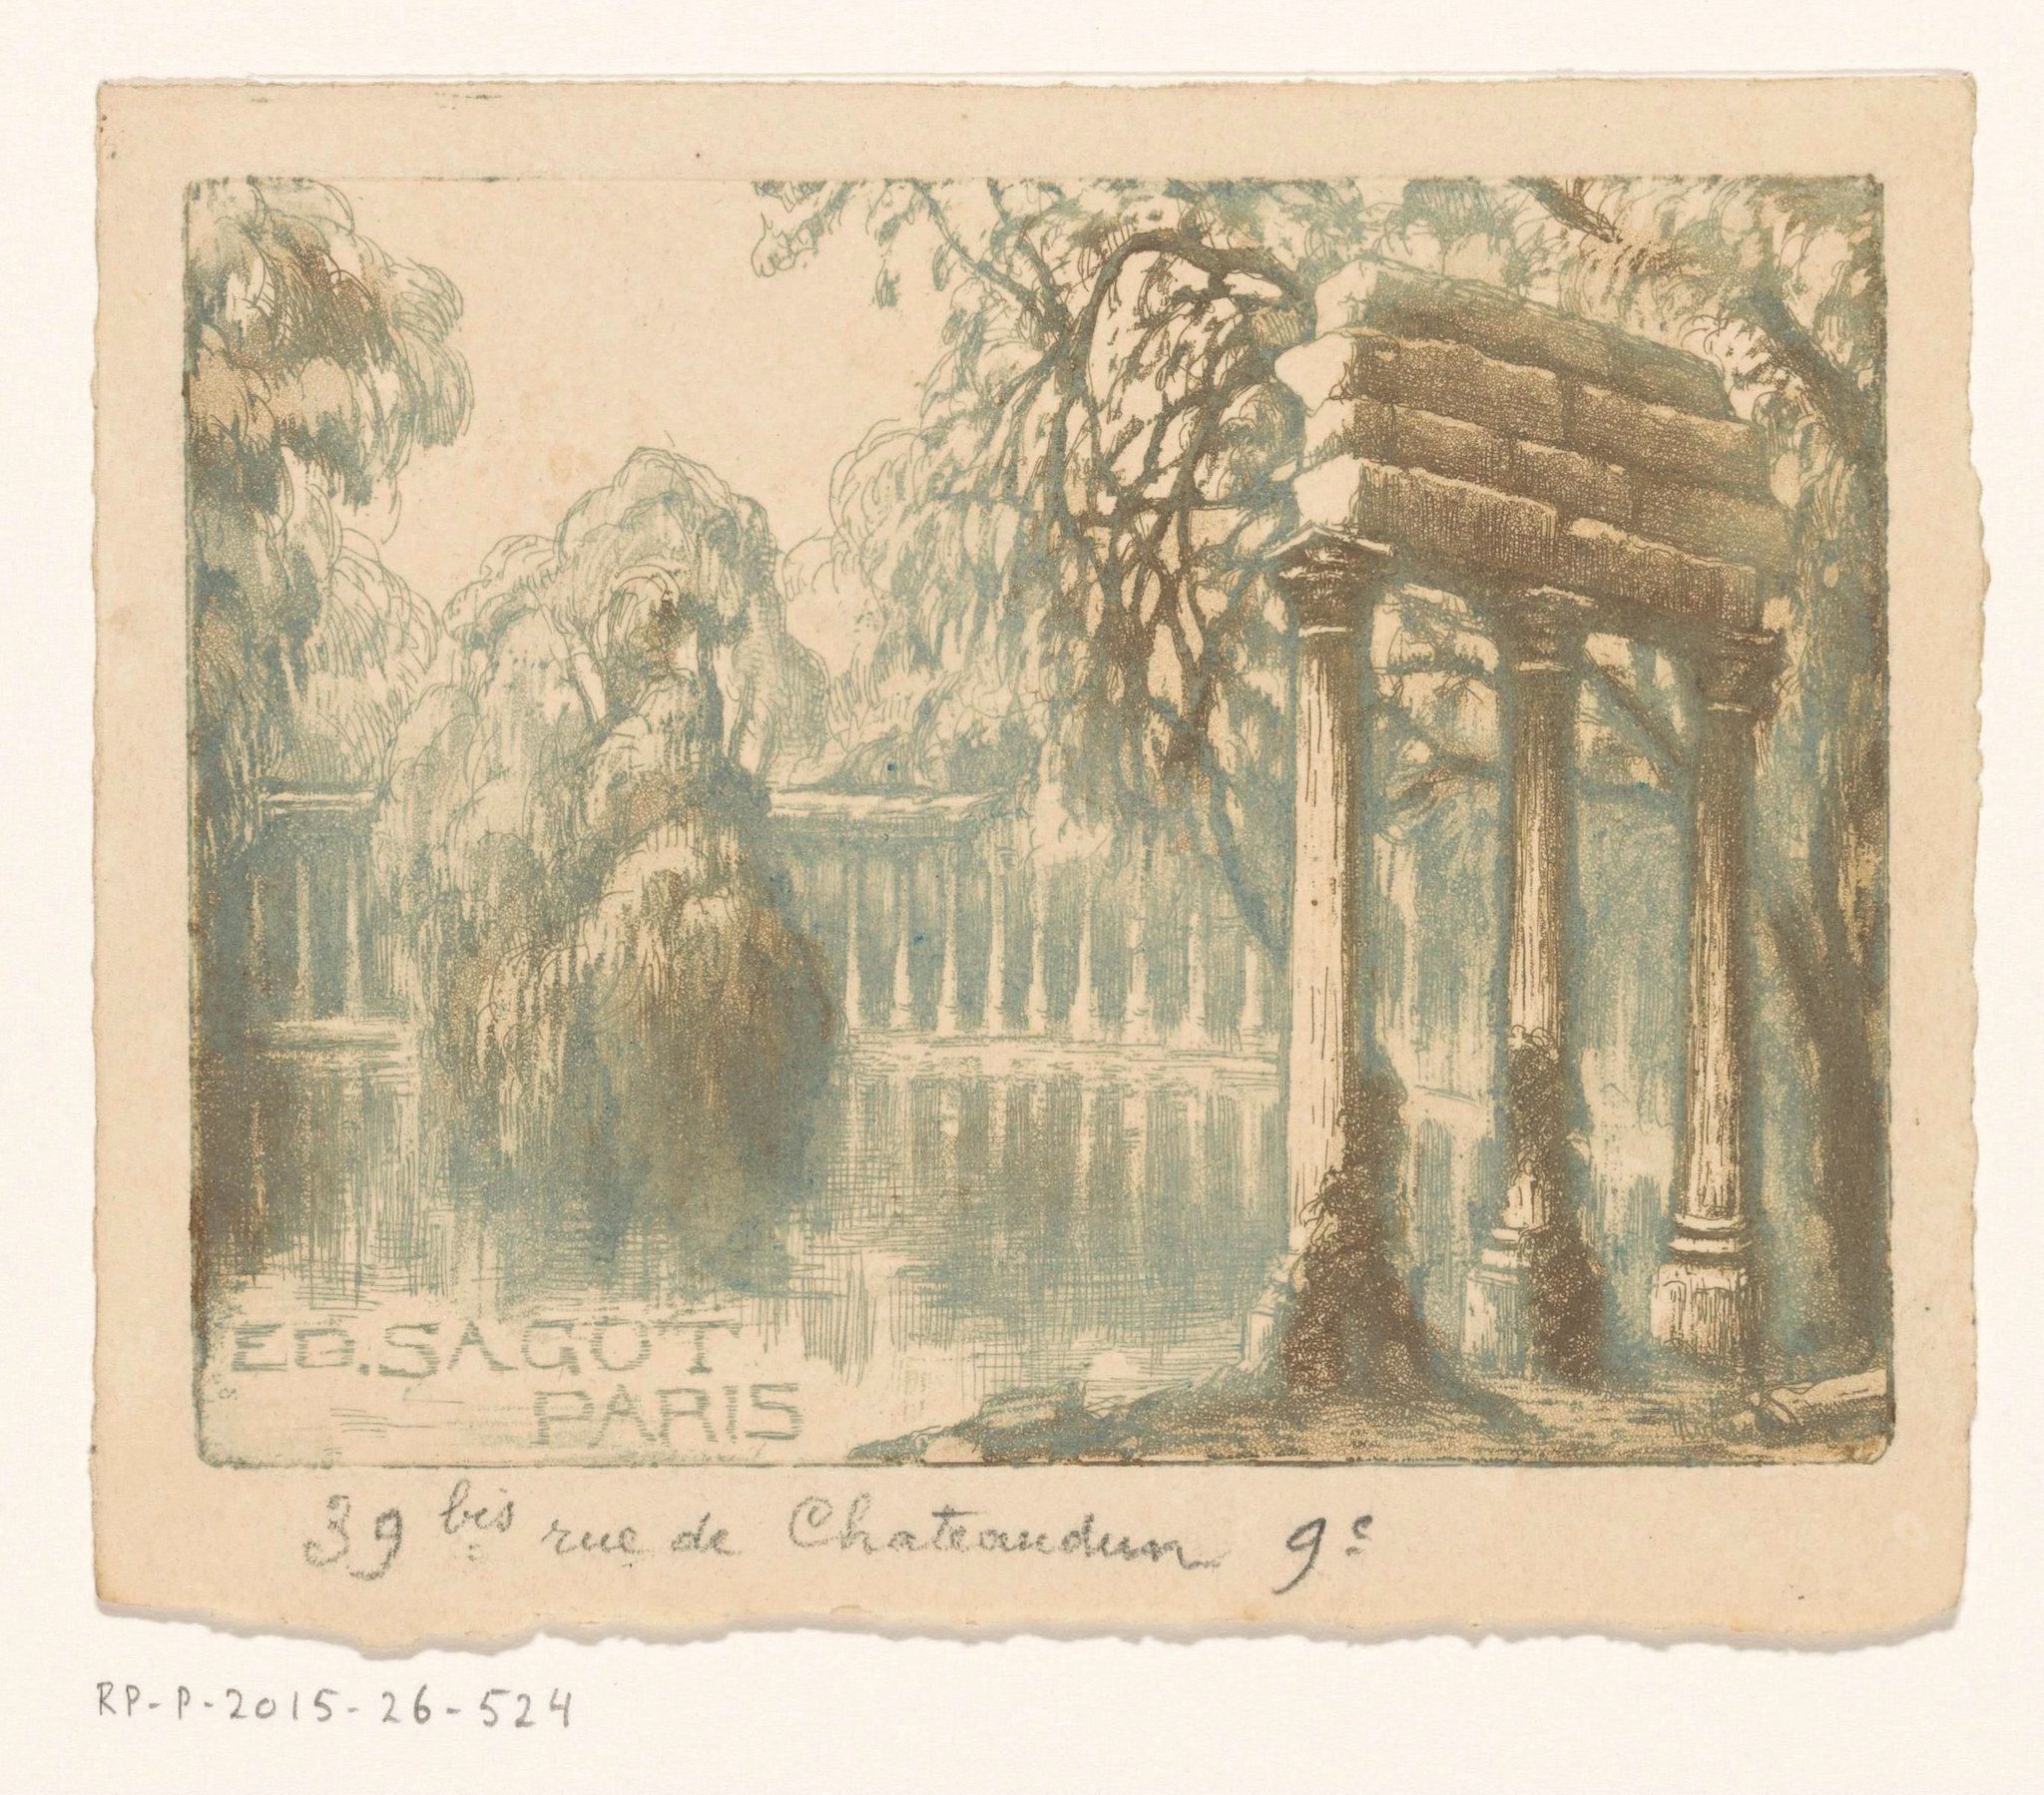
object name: visiting card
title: Visitekaartje van prenthandelaar Edmond Sagot te Parijs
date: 1890-1917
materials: paper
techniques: etching, soft ground etching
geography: paris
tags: colonnade, pond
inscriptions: annotation: ‘39bis rue de Chateaudun 9e’, collector's mark: Lugt 2228, collector's mark: Lugt 4779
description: Vijver met bomen en een antieke zuilengalerij.